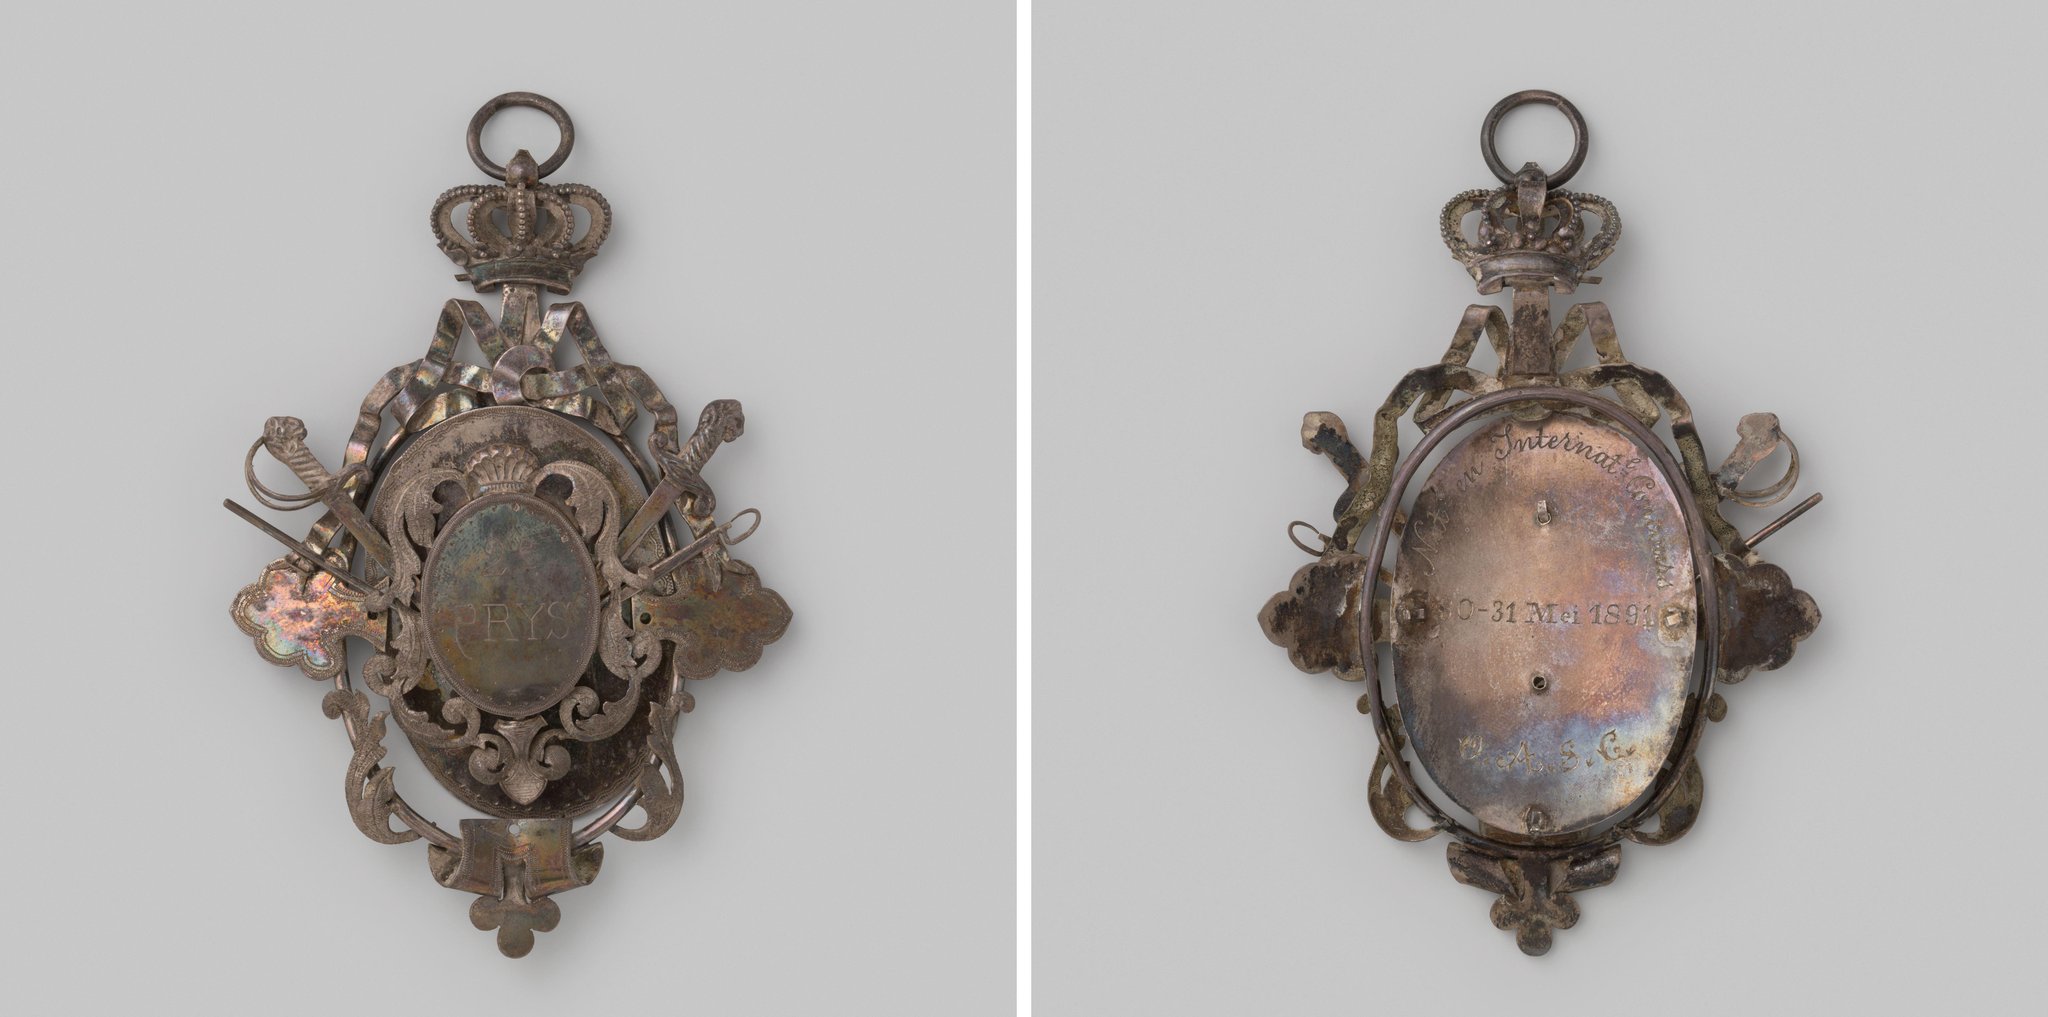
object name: medal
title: Prijspenning nationaal en internationaal concours van de onderlinge Amsterdamse schermcursus, behaald door de vereniging van onderofficieren van de schutterij te Amsterdam, tweede Colonneprijs voor schermen op het geweer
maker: Anonymous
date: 1891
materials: silver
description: Zilveren penning gedekt door een koningskroon met oog en ring.